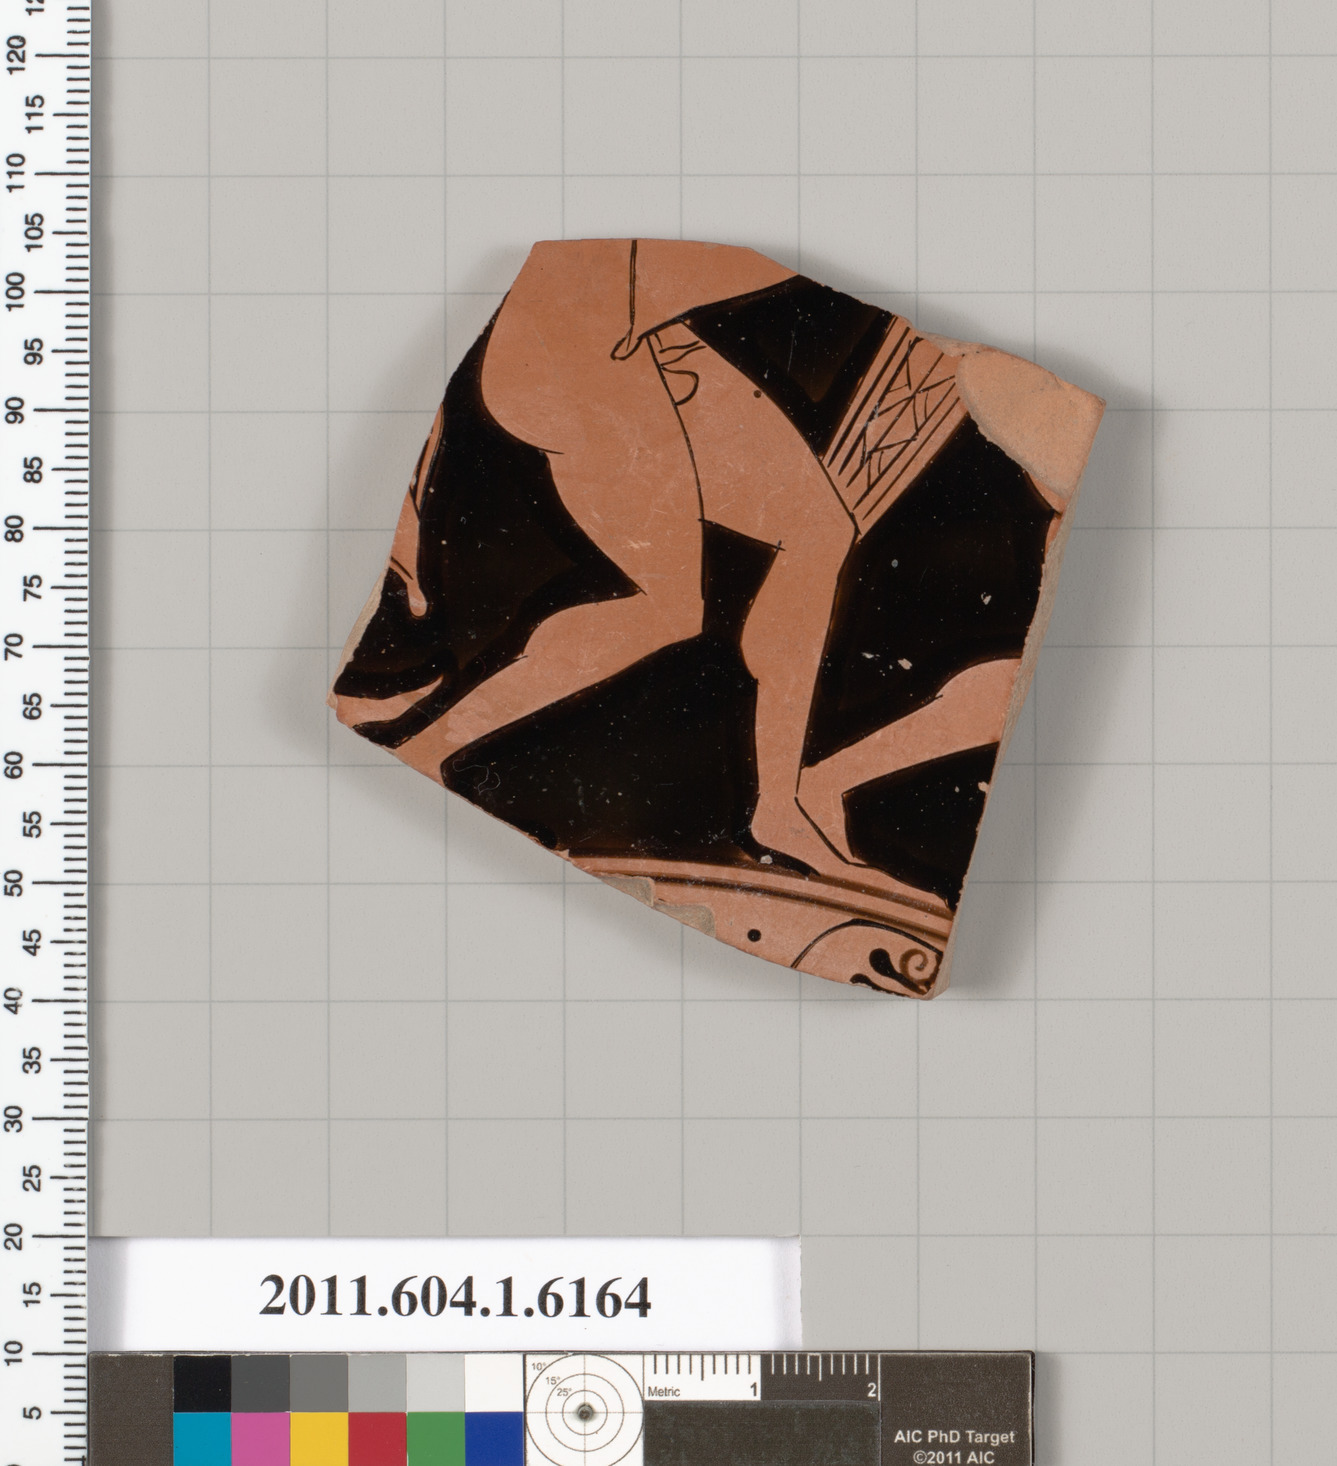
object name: kylix fragment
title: Terracotta fragment of a kylix (drinking cup)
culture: greek, attic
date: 520-500 BCE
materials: terracotta